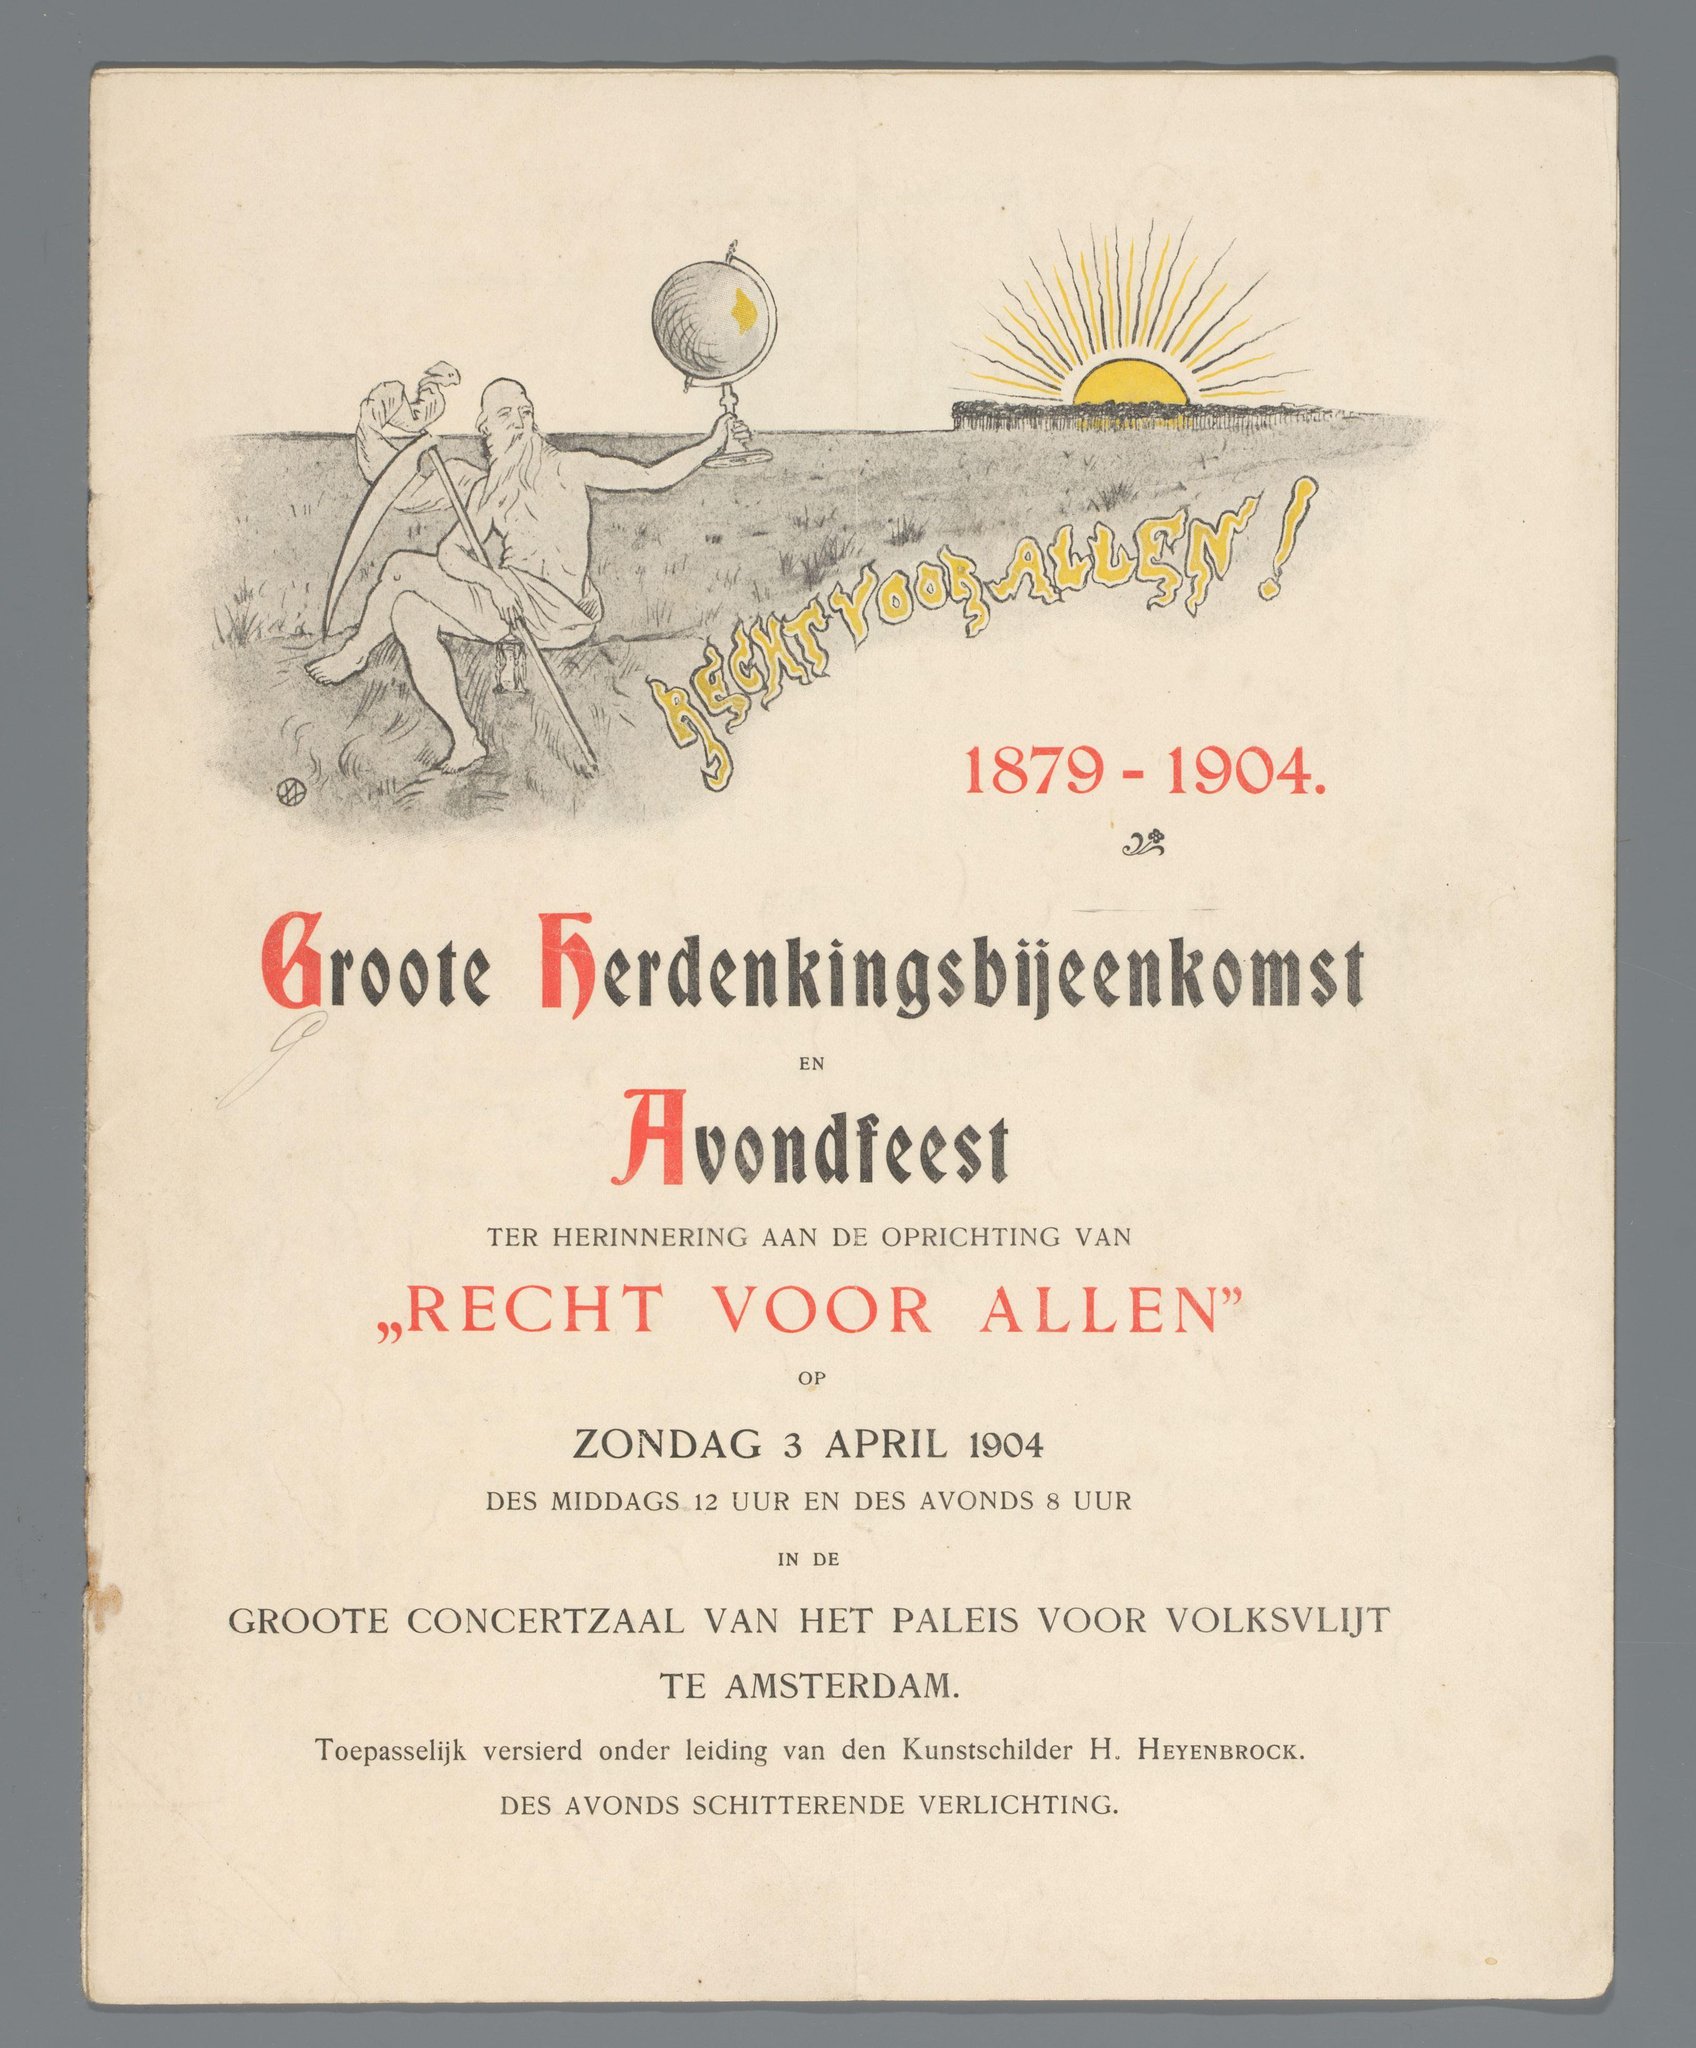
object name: brochure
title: Groote Herdenkingsbijeenkomst en Avondfeest ter herinnering aan de oprichting van "Recht voor Allen"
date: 1904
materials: paper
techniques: printing, stapling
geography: amsterdam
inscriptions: date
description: 25-jarig bestaan van 'Recht voor Allen', 1904